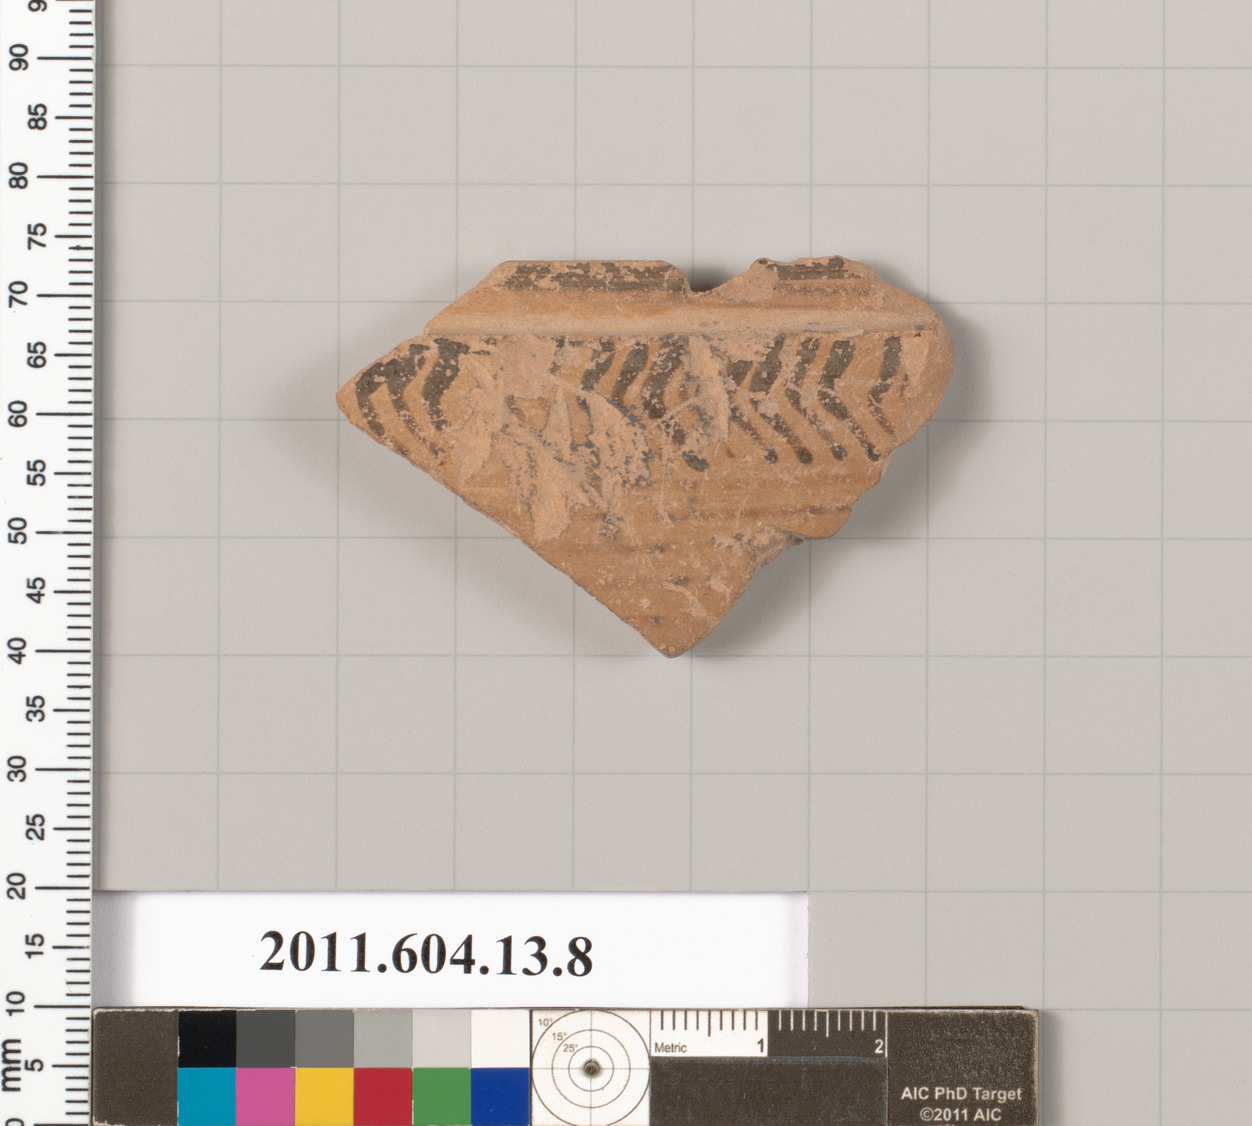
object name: skyphos fragment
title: Terracotta fragment of a skyphos (deep drinking cup)?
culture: east greek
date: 700-501 BCE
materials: terracotta